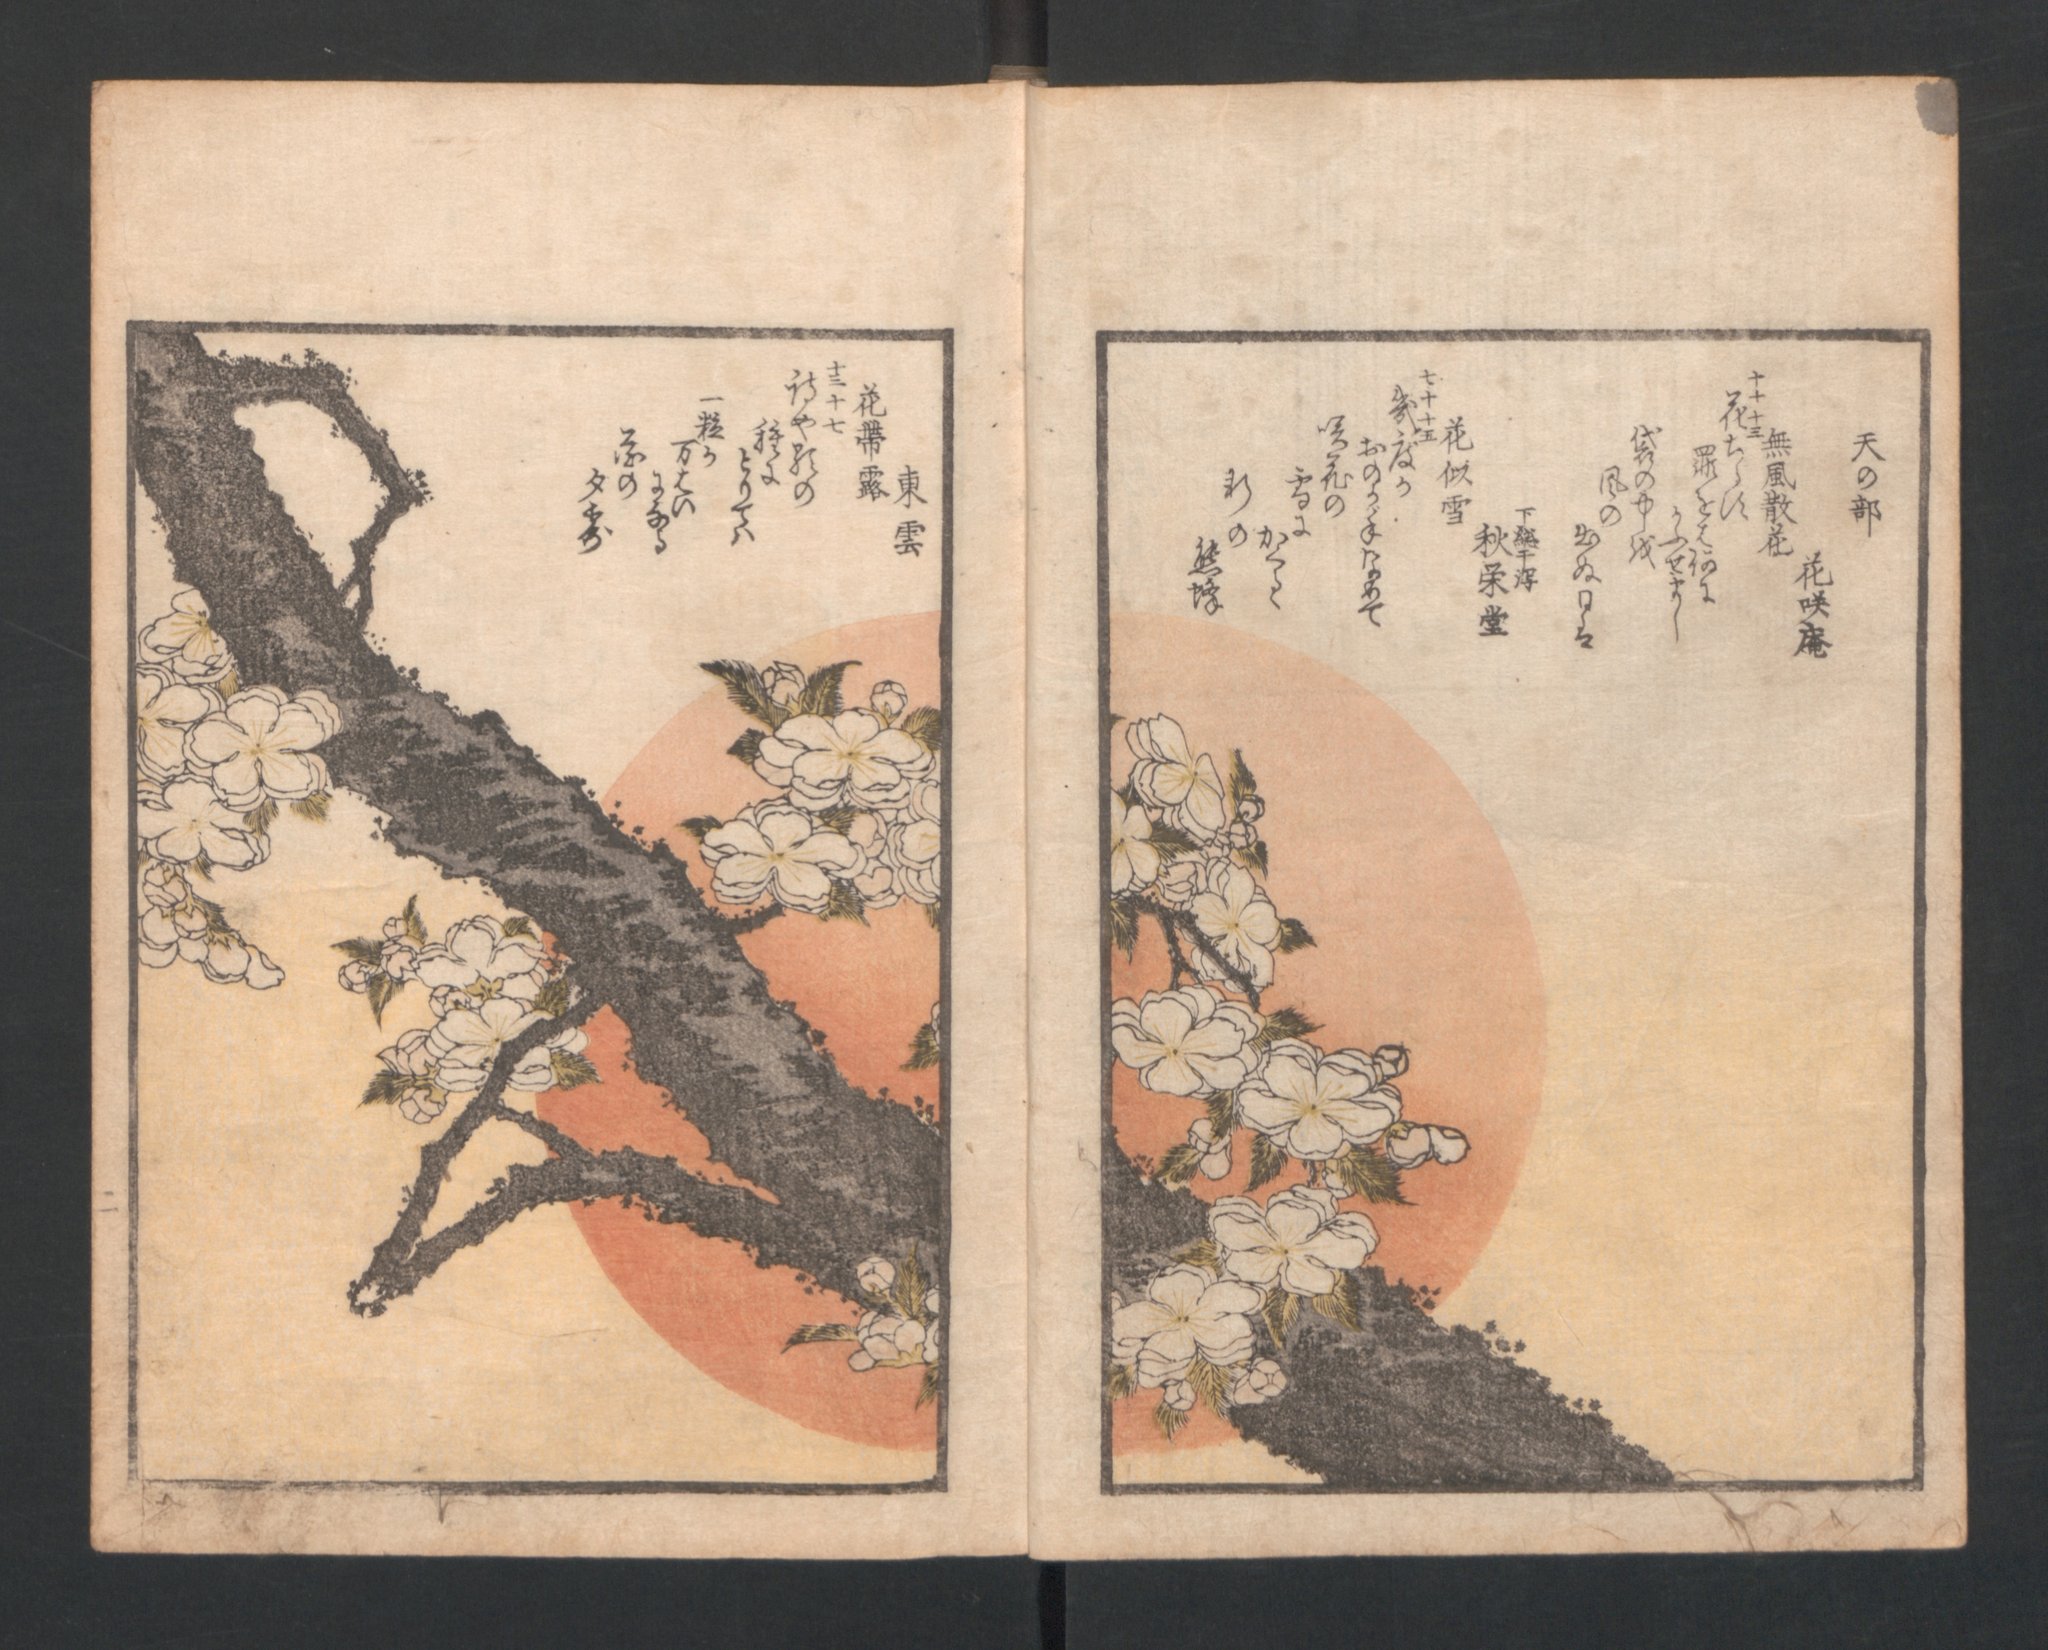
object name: illustrated book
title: One Hundred Comic Poems of the Flower, One of the Three Friends, Tsuki, the Moon, Yuki, the Snow, and Hana, the Flower (Sansai hana hyakushu) 三才花百首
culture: japanese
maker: totoya hokkei 魚屋北渓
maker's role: artist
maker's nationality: japanese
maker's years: 1780-1850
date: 1828-1830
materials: ink, paper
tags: flowers